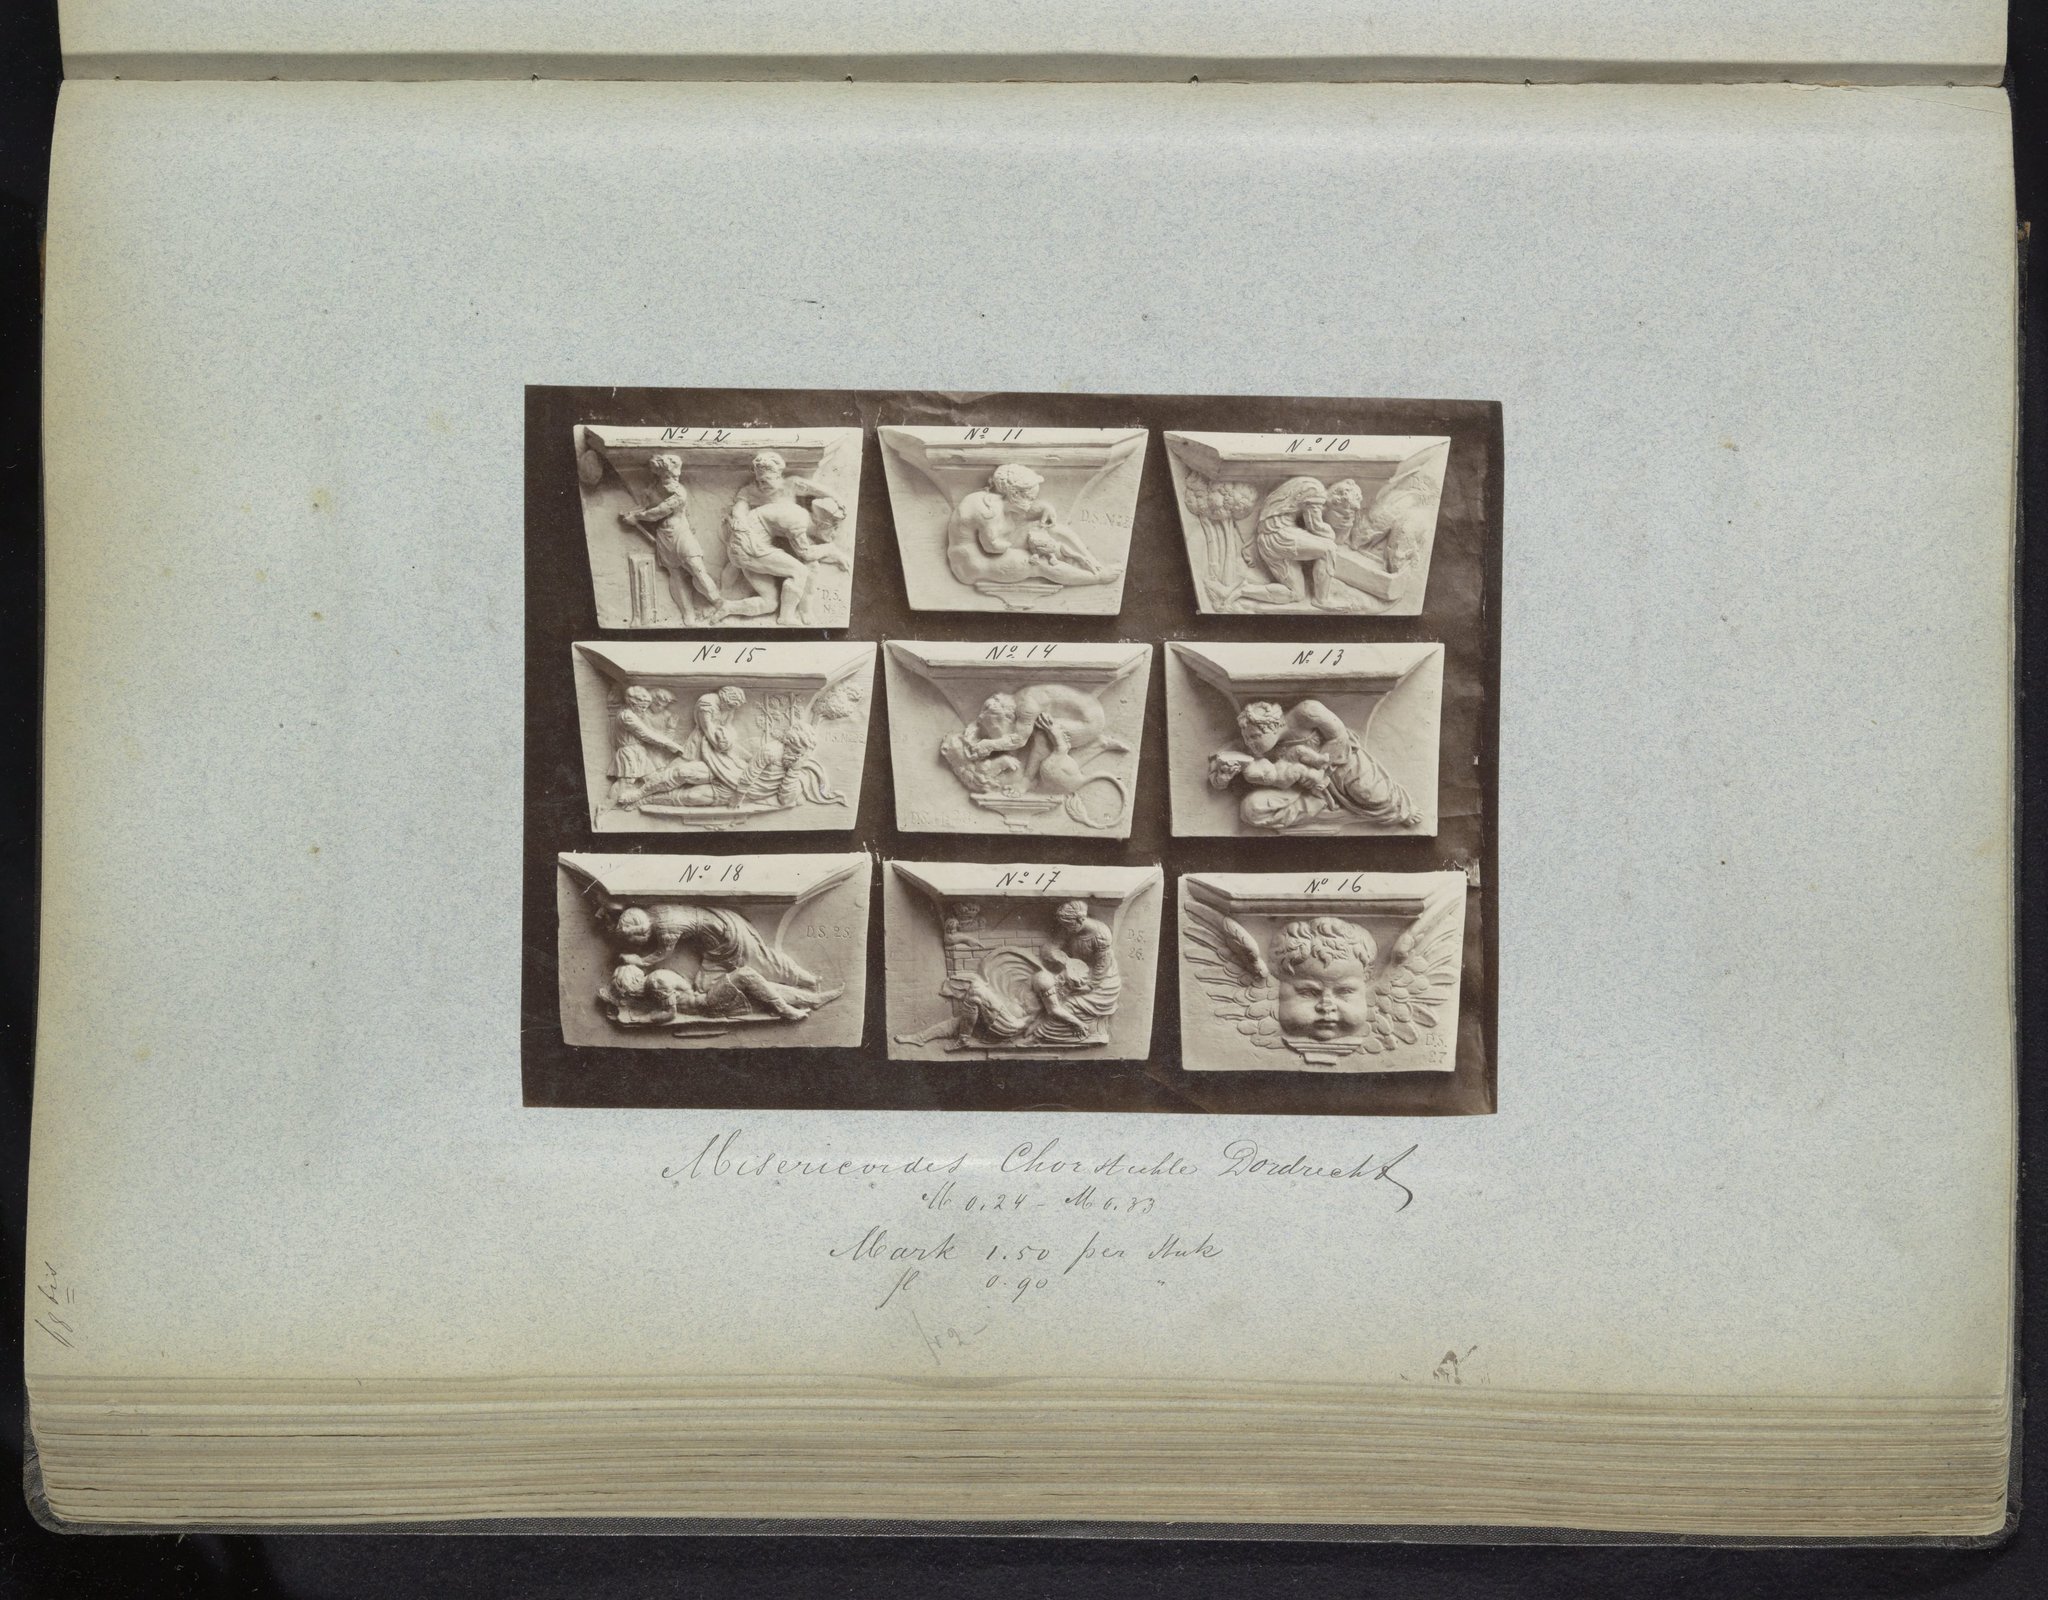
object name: photograph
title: Negen gipsen afgietsels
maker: Anonymous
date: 1875-1900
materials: paper, photographic support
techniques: albumen print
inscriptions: annotation: ‘Misericordes Chorstuhle Dordrecht’, annotation